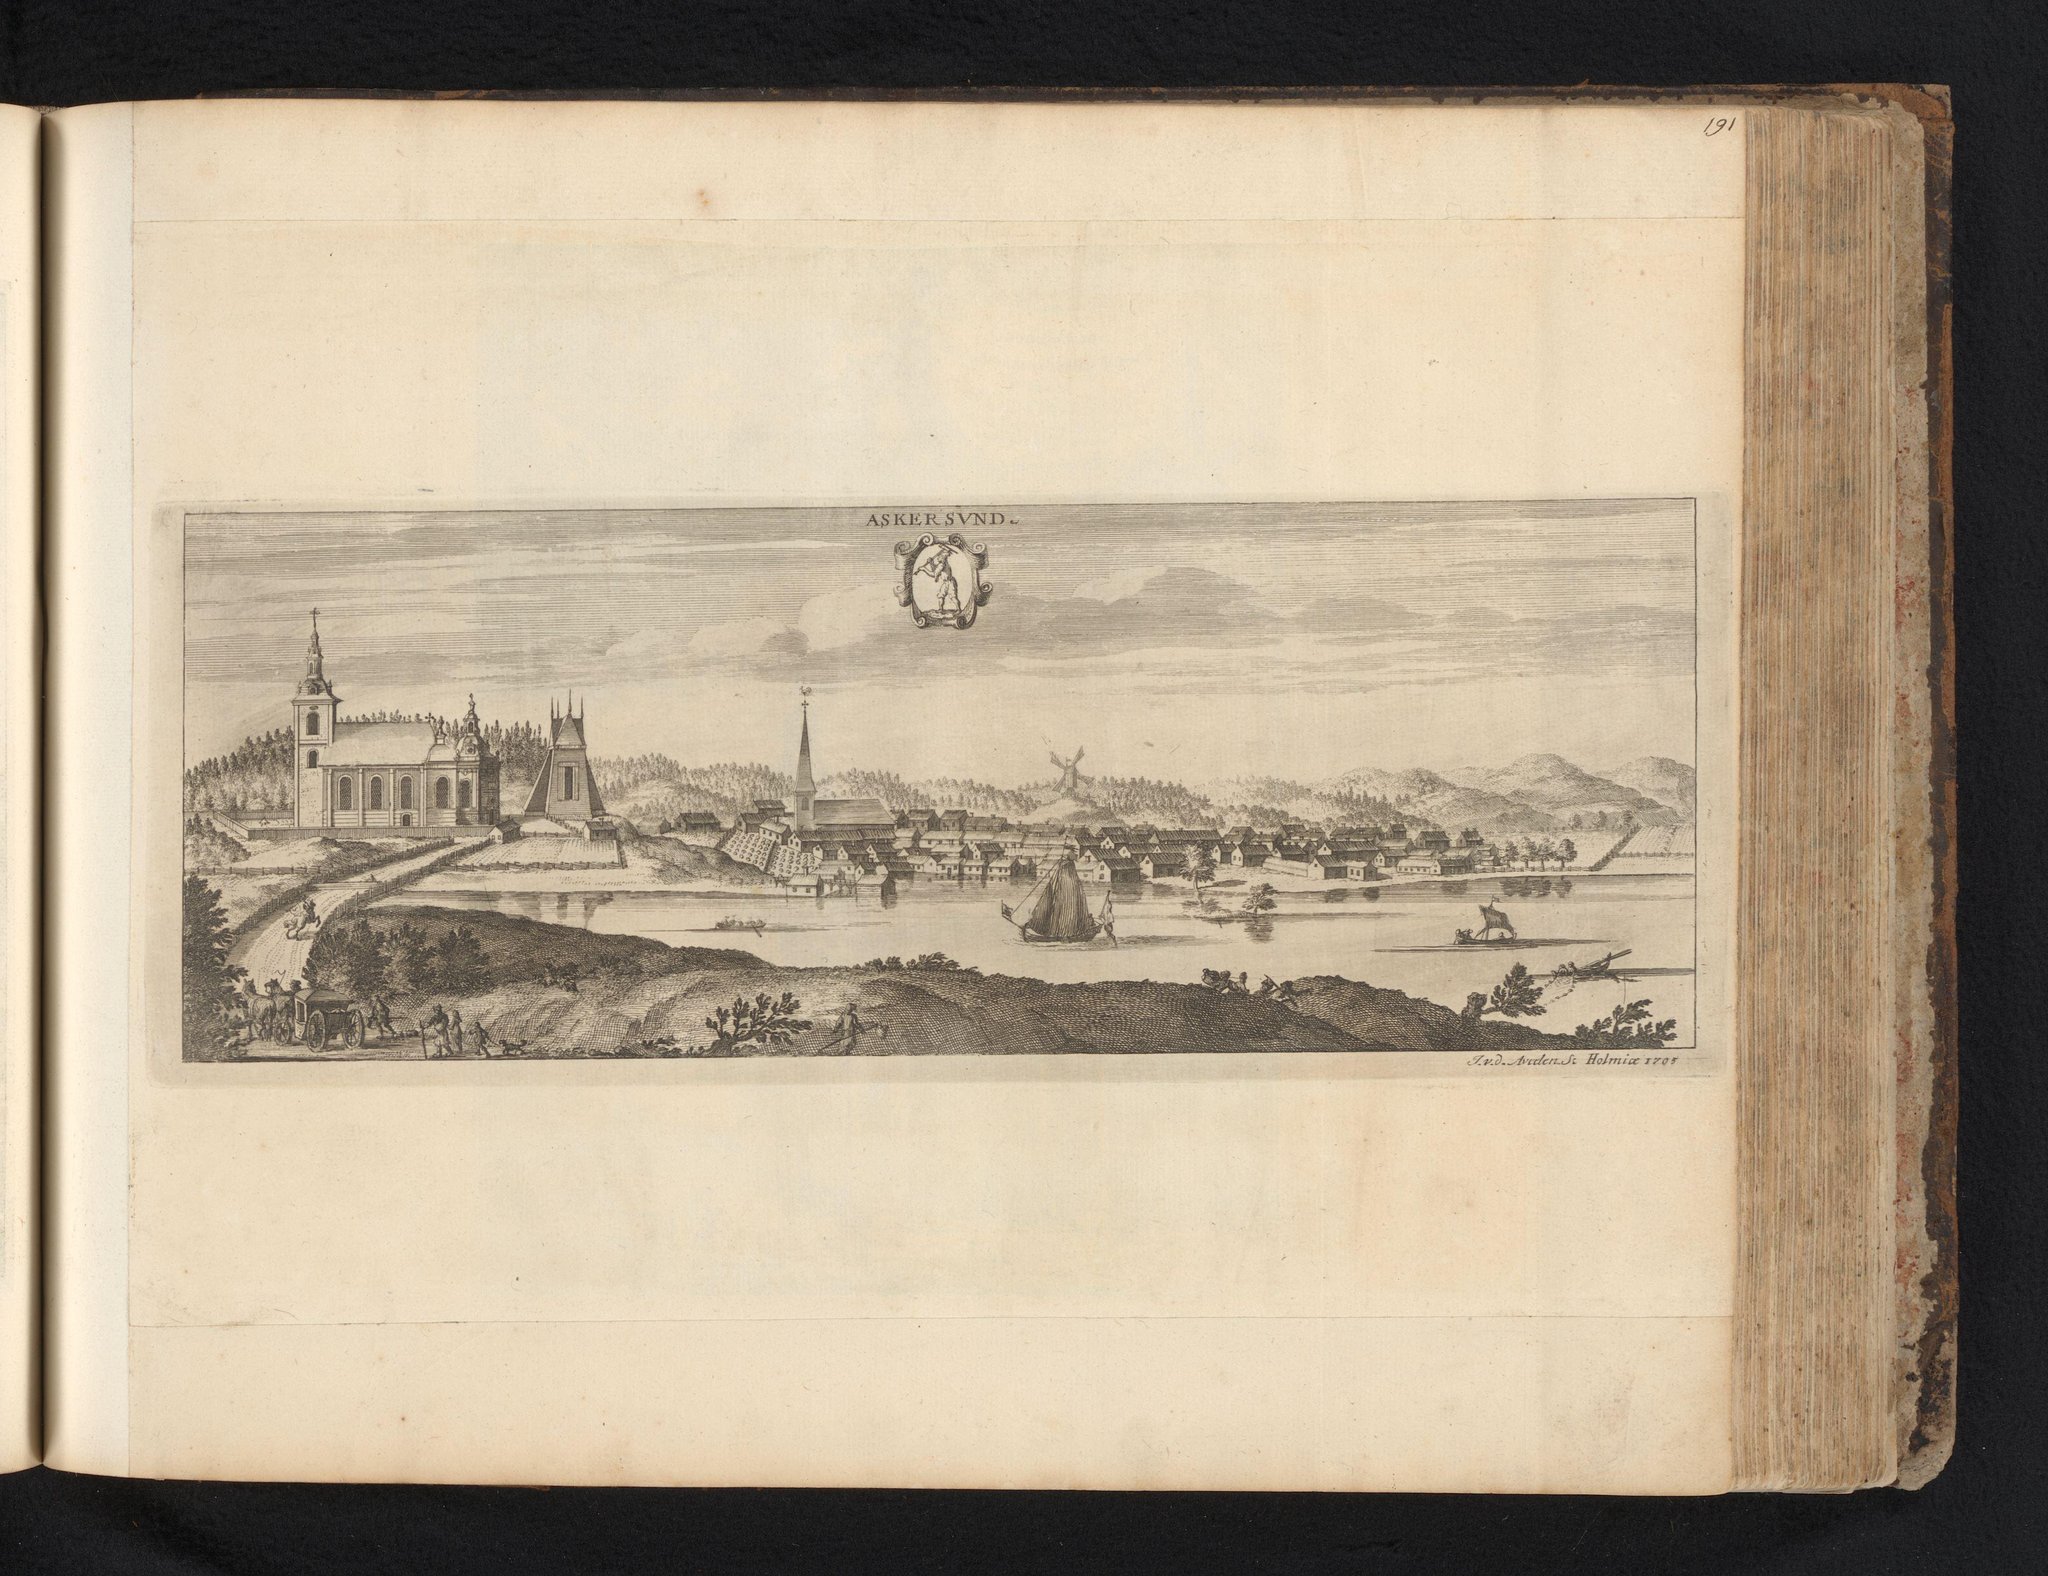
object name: print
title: Suecia Antiqua et Hodierna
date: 1705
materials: paper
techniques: etching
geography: stockholm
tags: city-view in general; 'veduta'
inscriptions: date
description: Kungliga Biblioteket, 'Suecia': http://www.kb.se/samlingarna/Kartor-bilder/Suecia-antiqua/ (geraadpleegd november 2016).